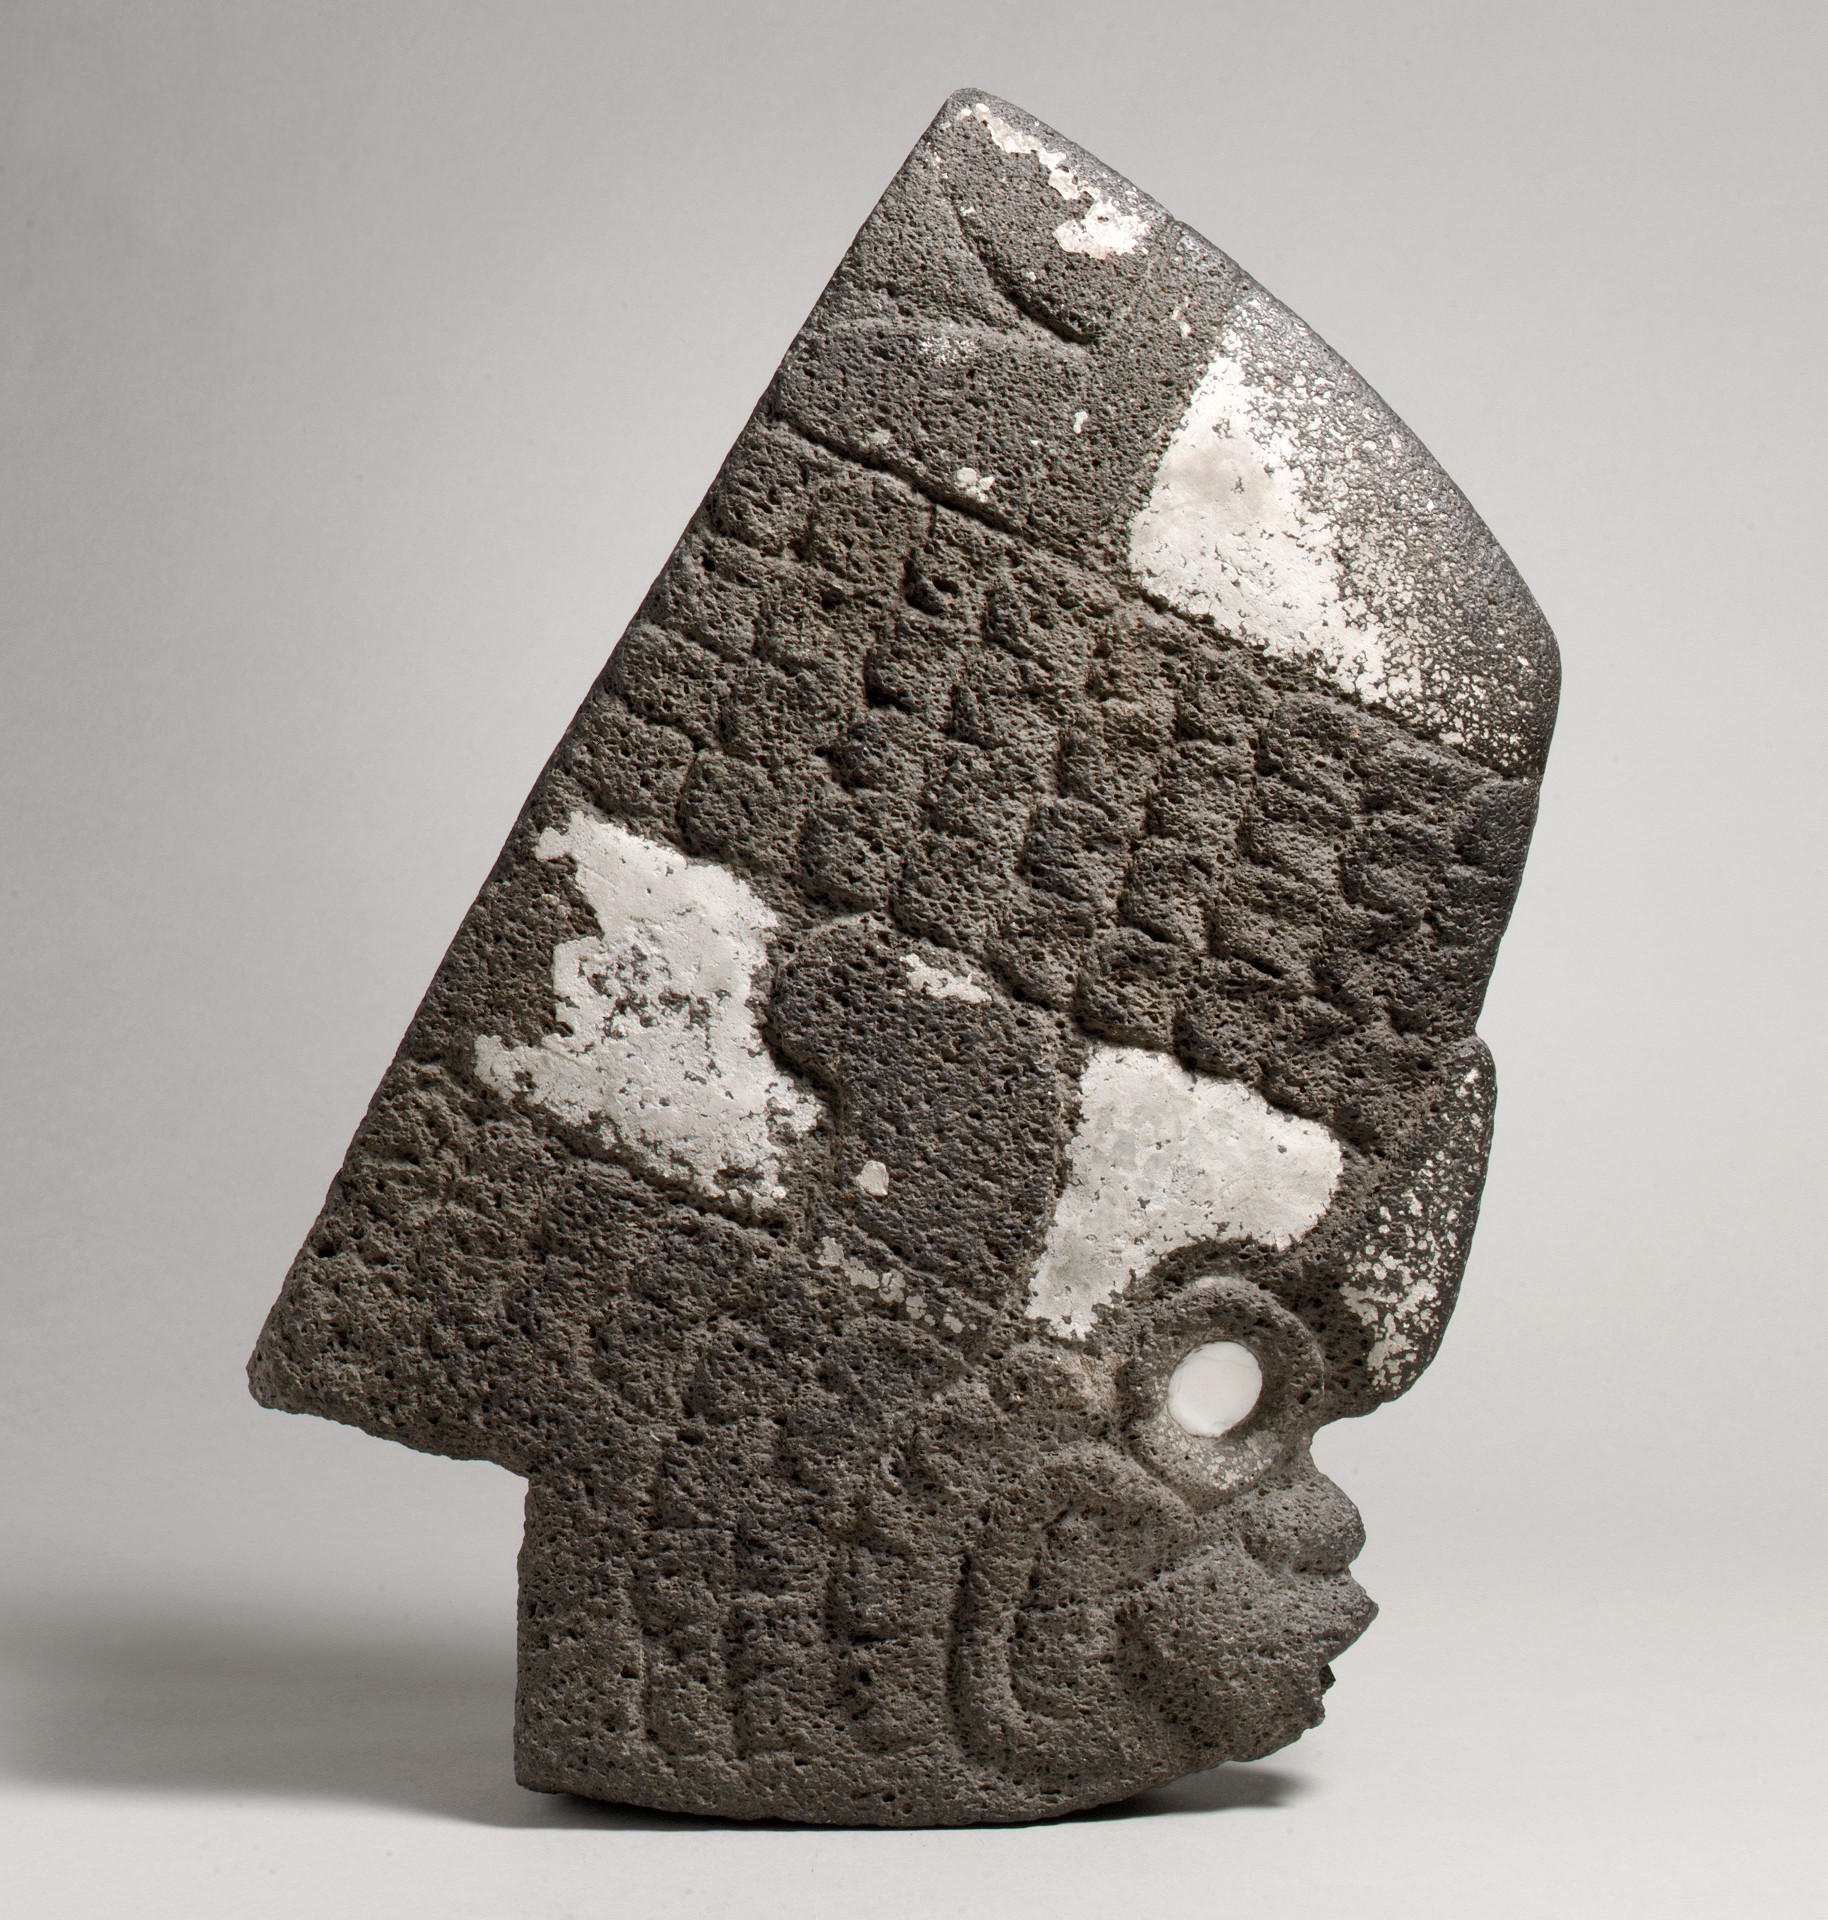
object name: hacha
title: Fish hacha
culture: classic veracruz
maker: classic veracruz artist(s)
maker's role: artist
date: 600-900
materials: pigment, plaster, shell, stone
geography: mexico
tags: fish